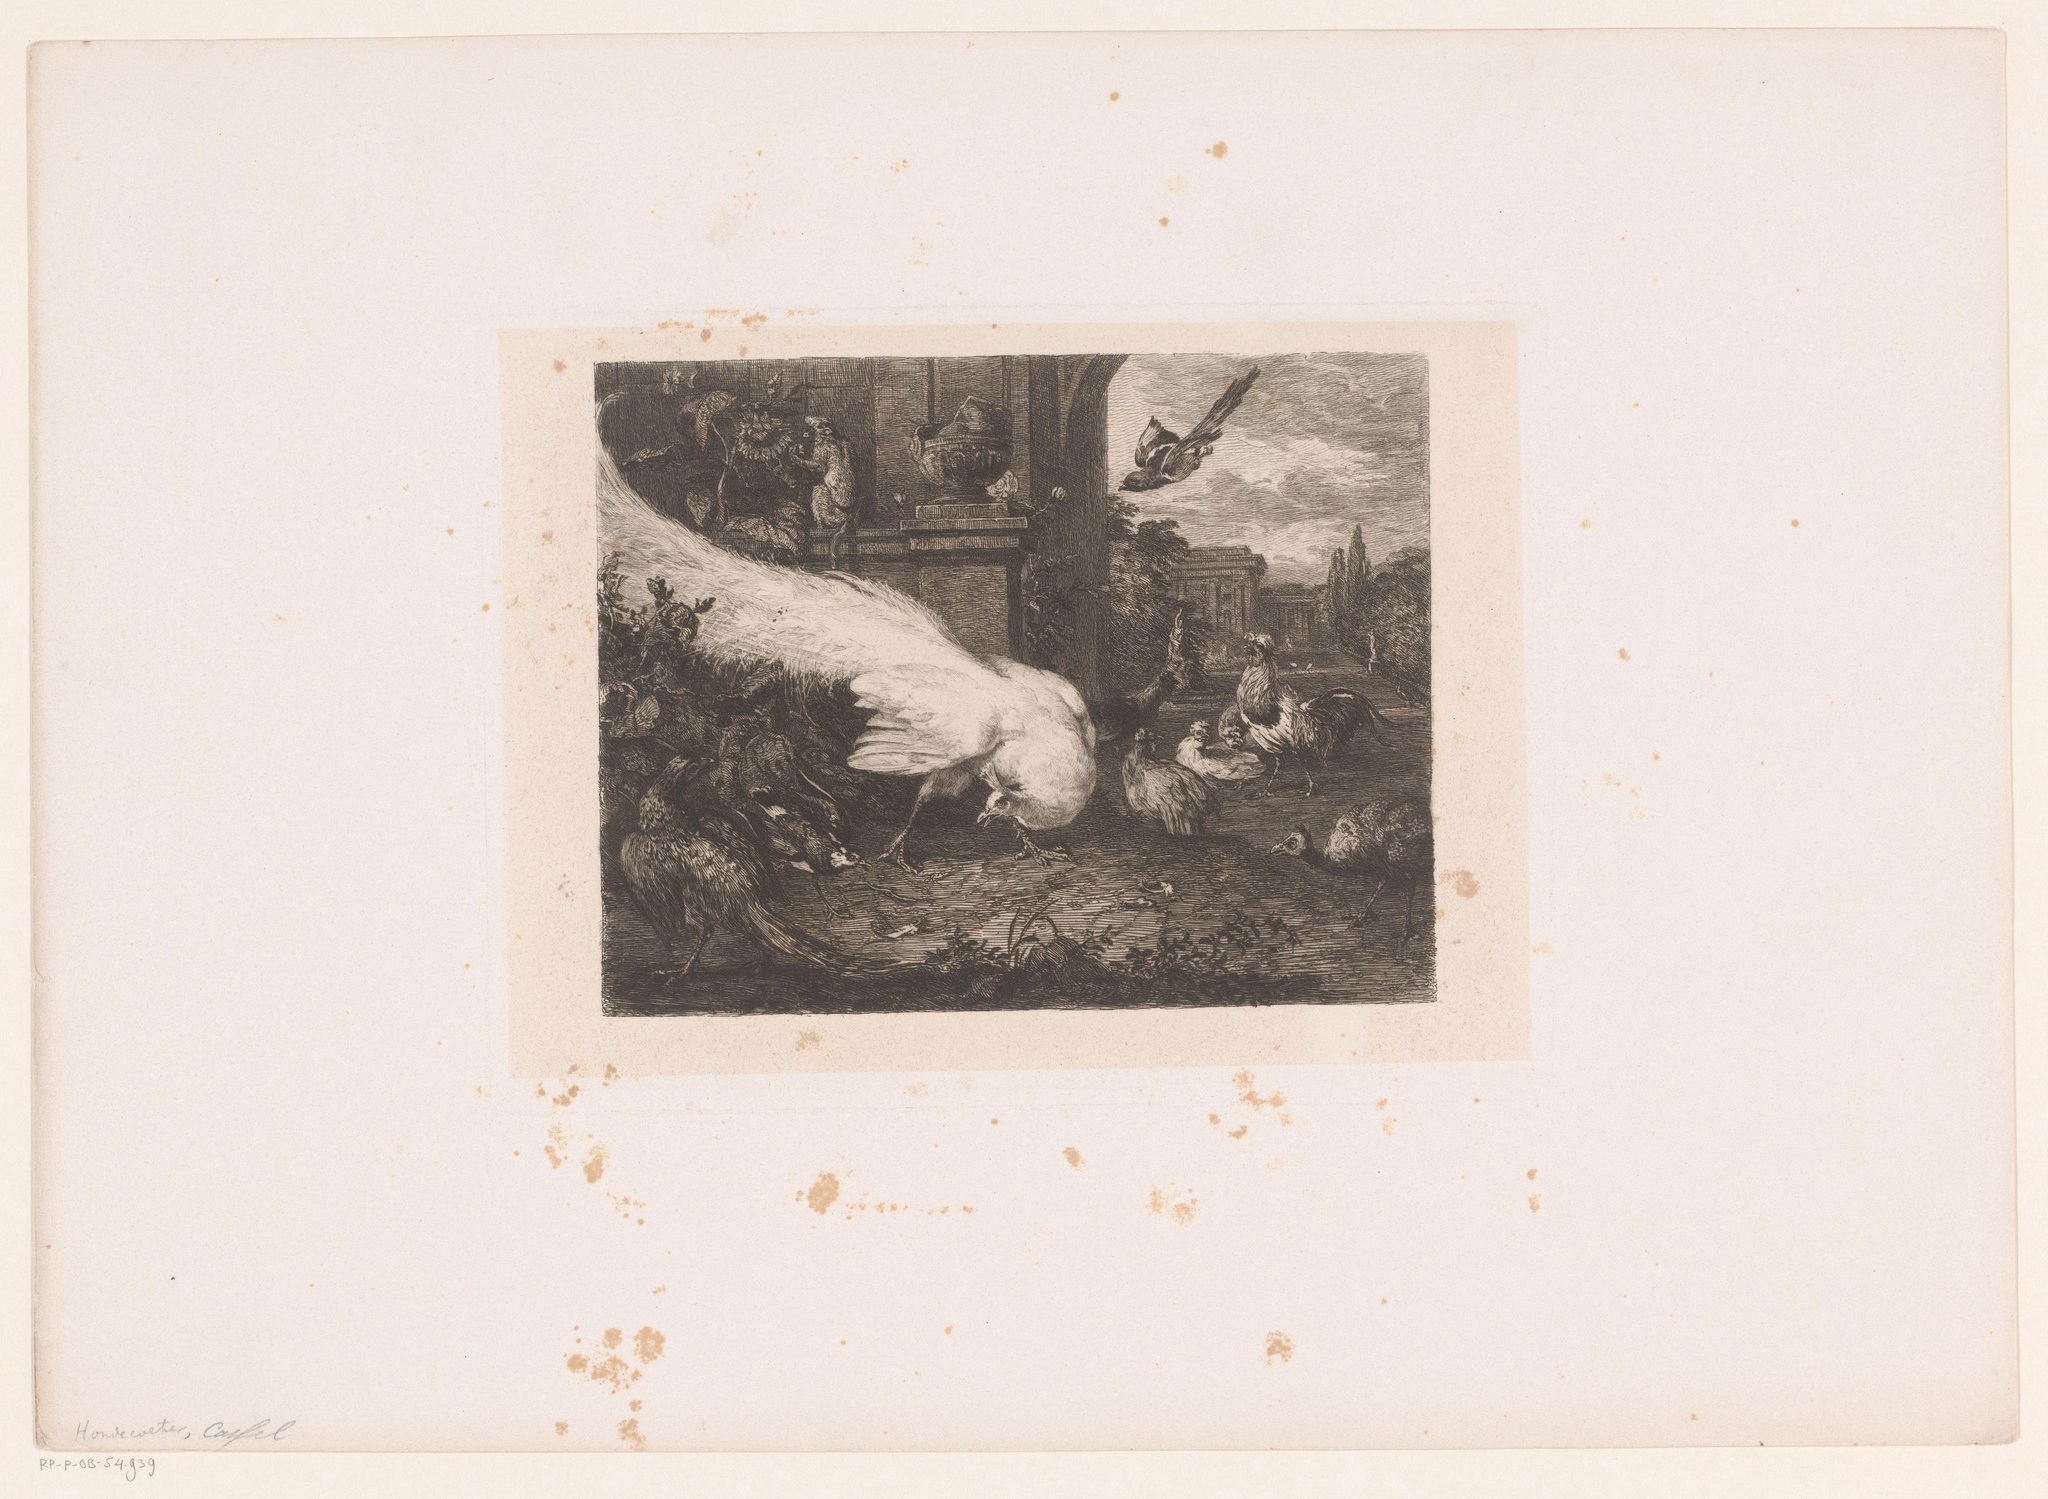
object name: print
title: Witte pauw en ander gevogelte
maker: william unger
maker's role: draughtsman, painter, print maker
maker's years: 1837-1932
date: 1847-1889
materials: paper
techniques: etching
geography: germany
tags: ornamental birds: peacock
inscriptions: collector's mark: Lugt 2228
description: Prent naar het schilderij door Melchior d' Hondecoeter in de Gemäldegalerie Alte Meister te Kassel (inv.nr. GK 381).